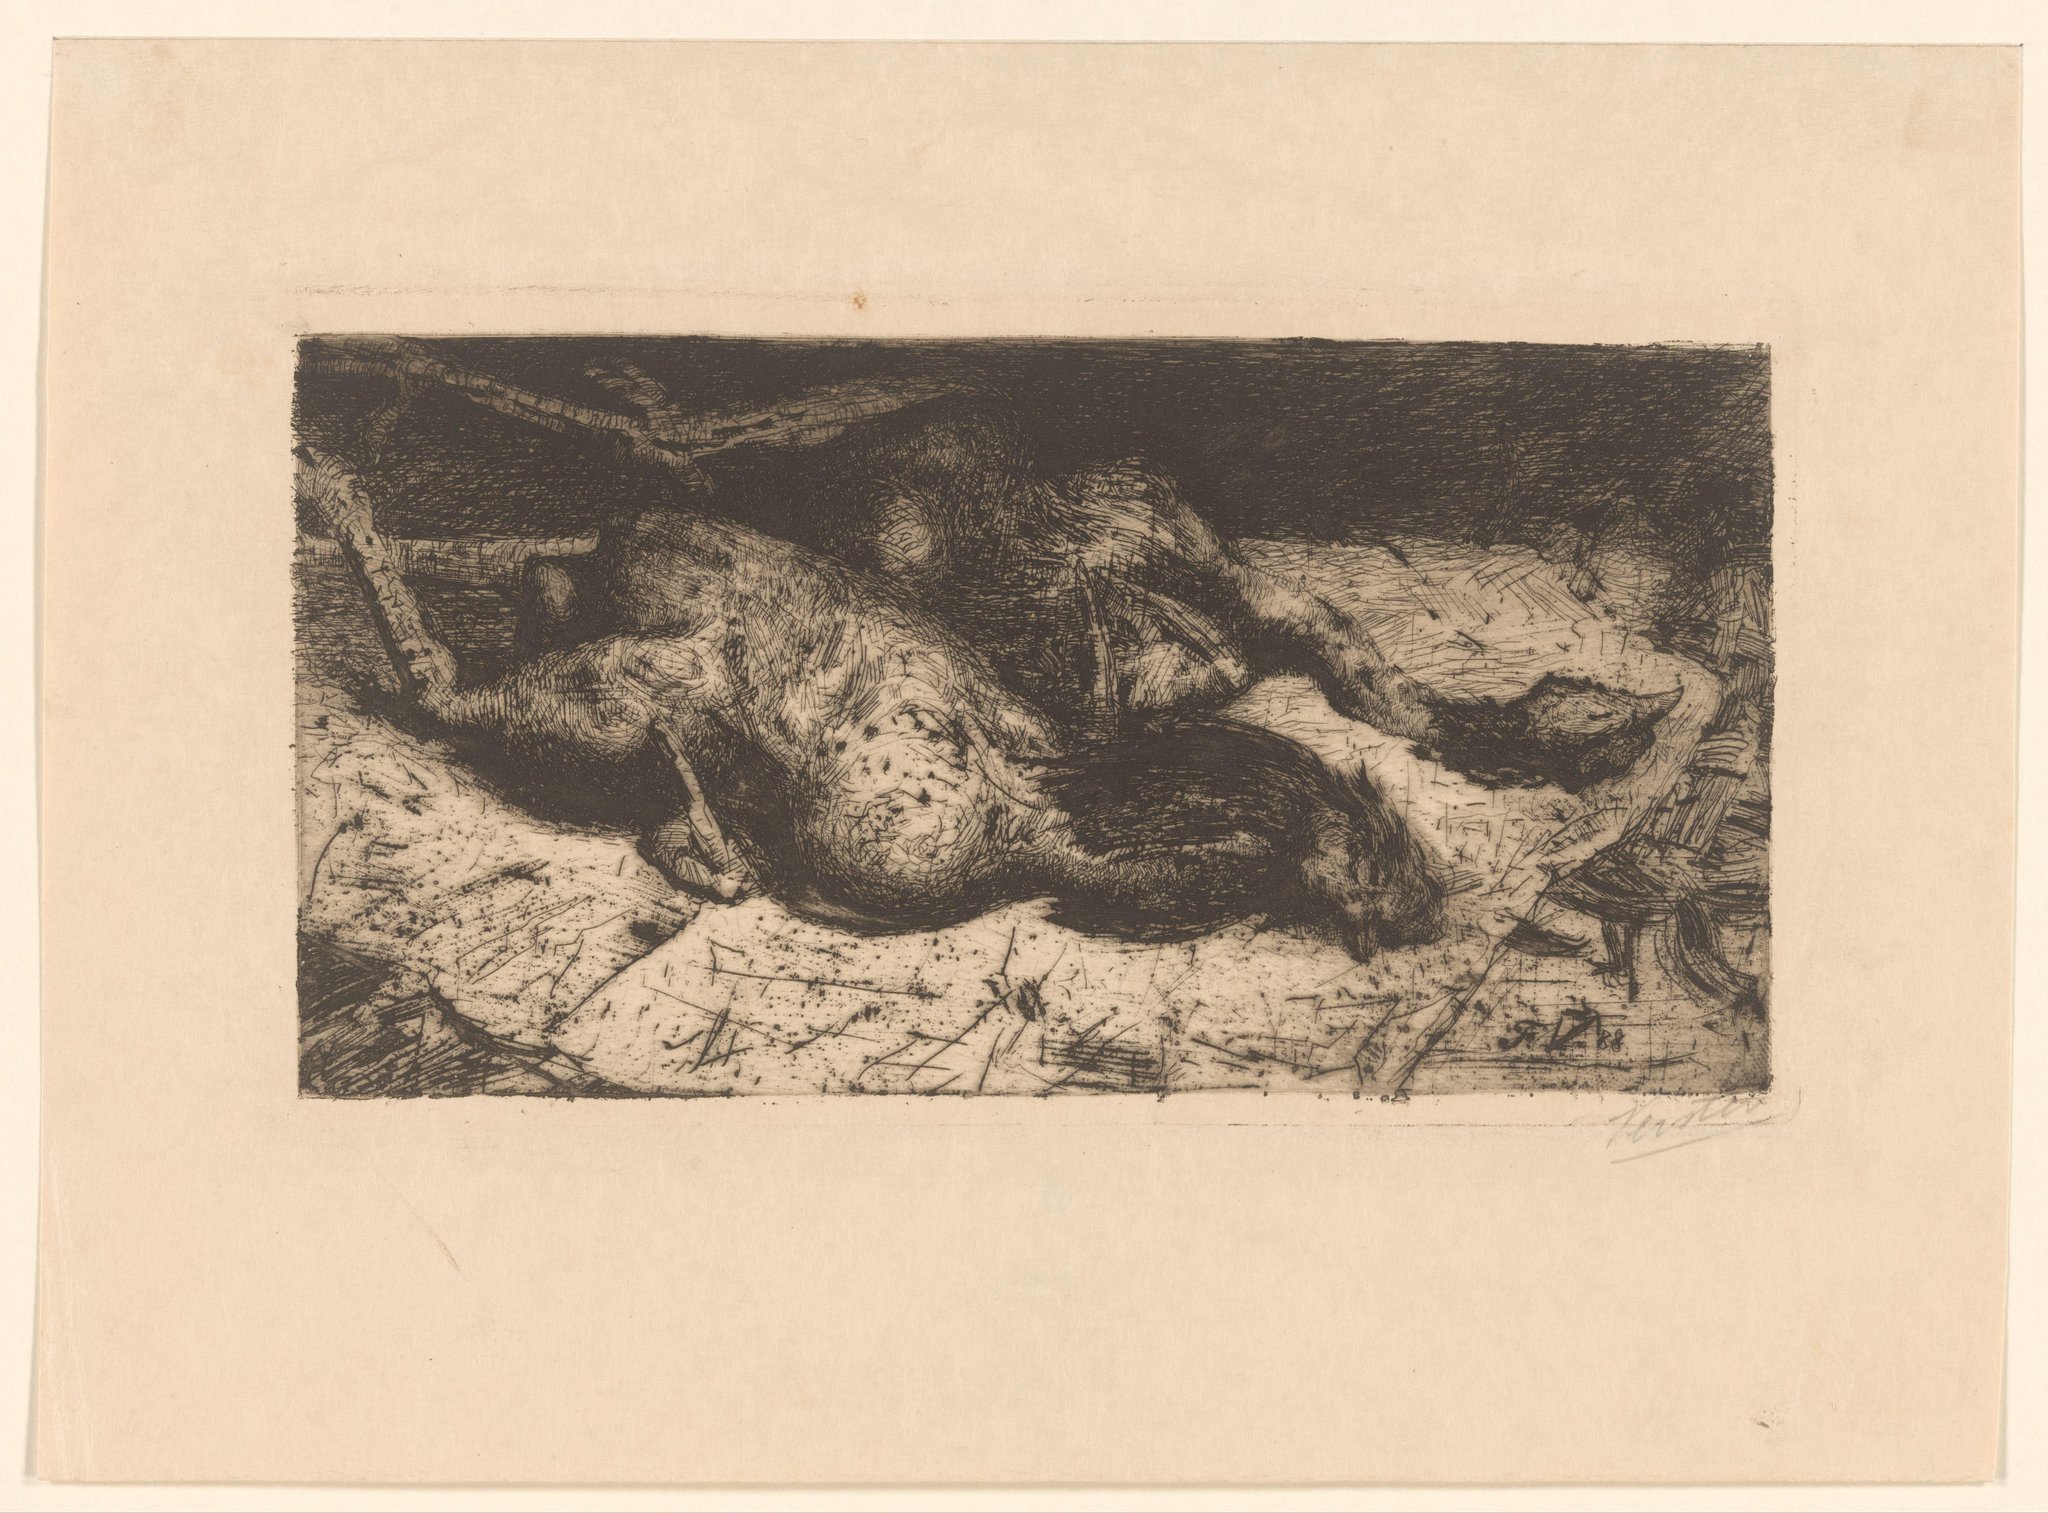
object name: print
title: Geplukte hanen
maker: floris verster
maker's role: draughtsman, painter, print maker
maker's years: 1861-1927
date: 1888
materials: paper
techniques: drypoint, etching, intaglio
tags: fowl (cock, hen, chicken, etc.)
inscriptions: collector's mark: Lugt 2228, collector's mark: Lugt 2760